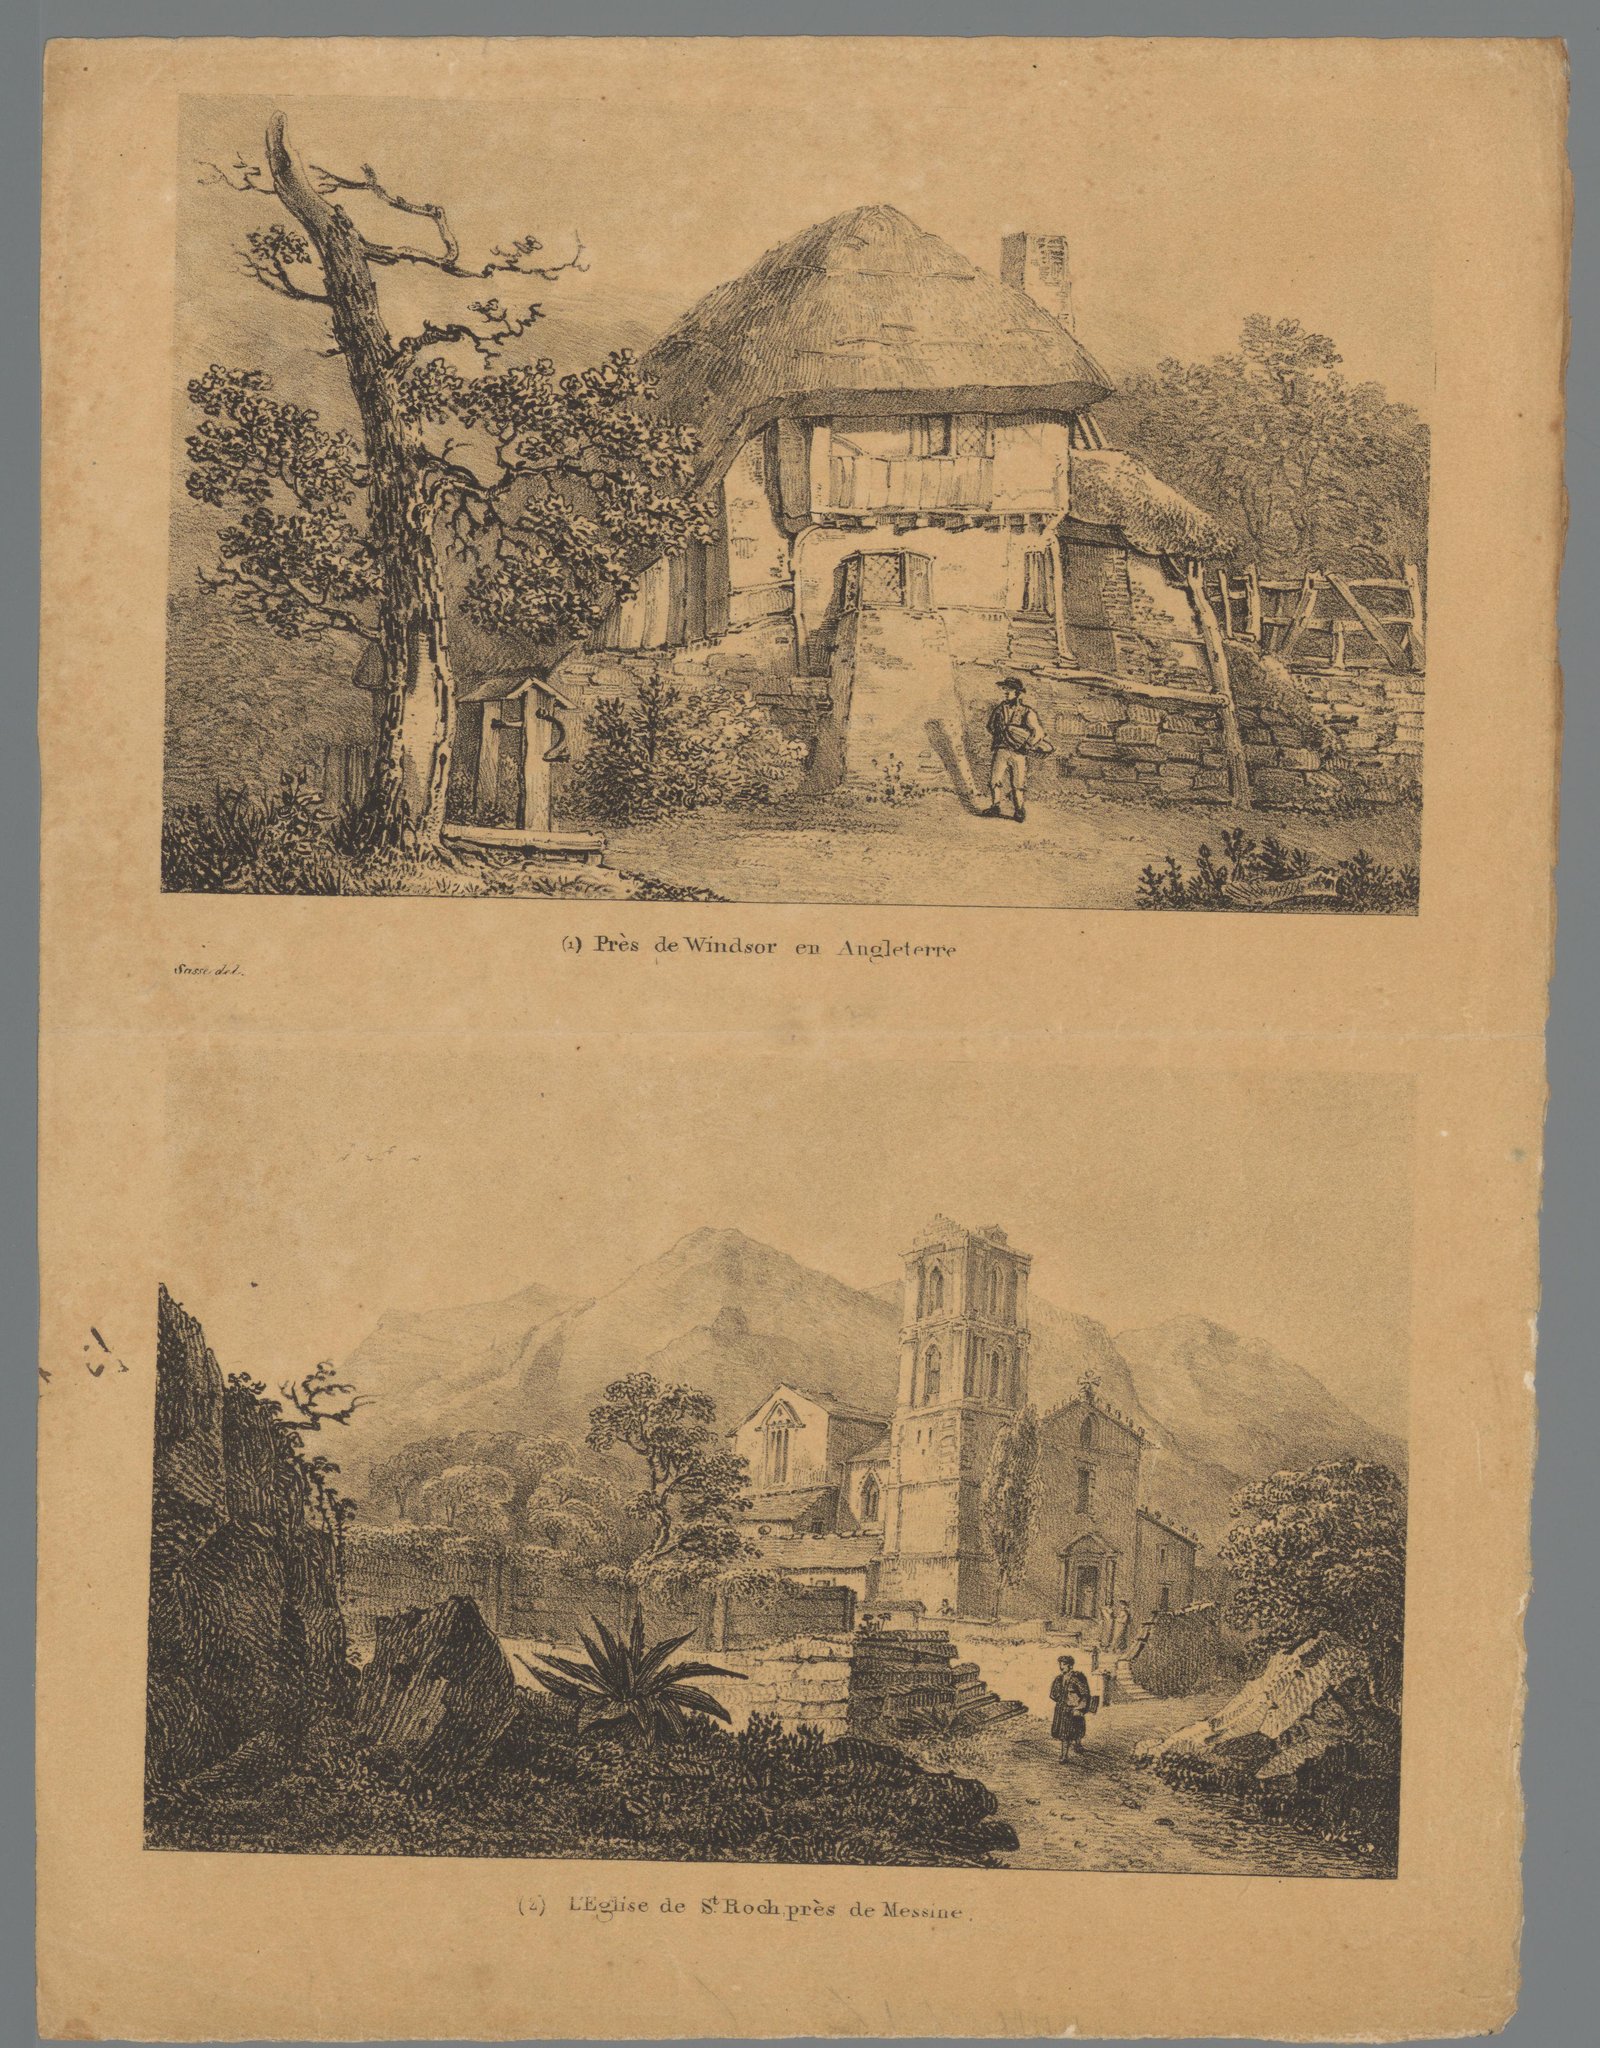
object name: print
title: Près de Windsor en Angleterre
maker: richard sasse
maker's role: print maker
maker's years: 1774-1849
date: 1800-1849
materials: paper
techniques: lithograph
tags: church (exterior), landscapes in the temperate zone (+ landscape with figures, staffage), farm or solitary house in landscape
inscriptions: collector's mark: Lugt 2228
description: Prent behoort tot de serie 'L'art de dessiner le paysage d'apres nature'. Deze serie is in tien delen met elk zes lithografieën uitgegeven.